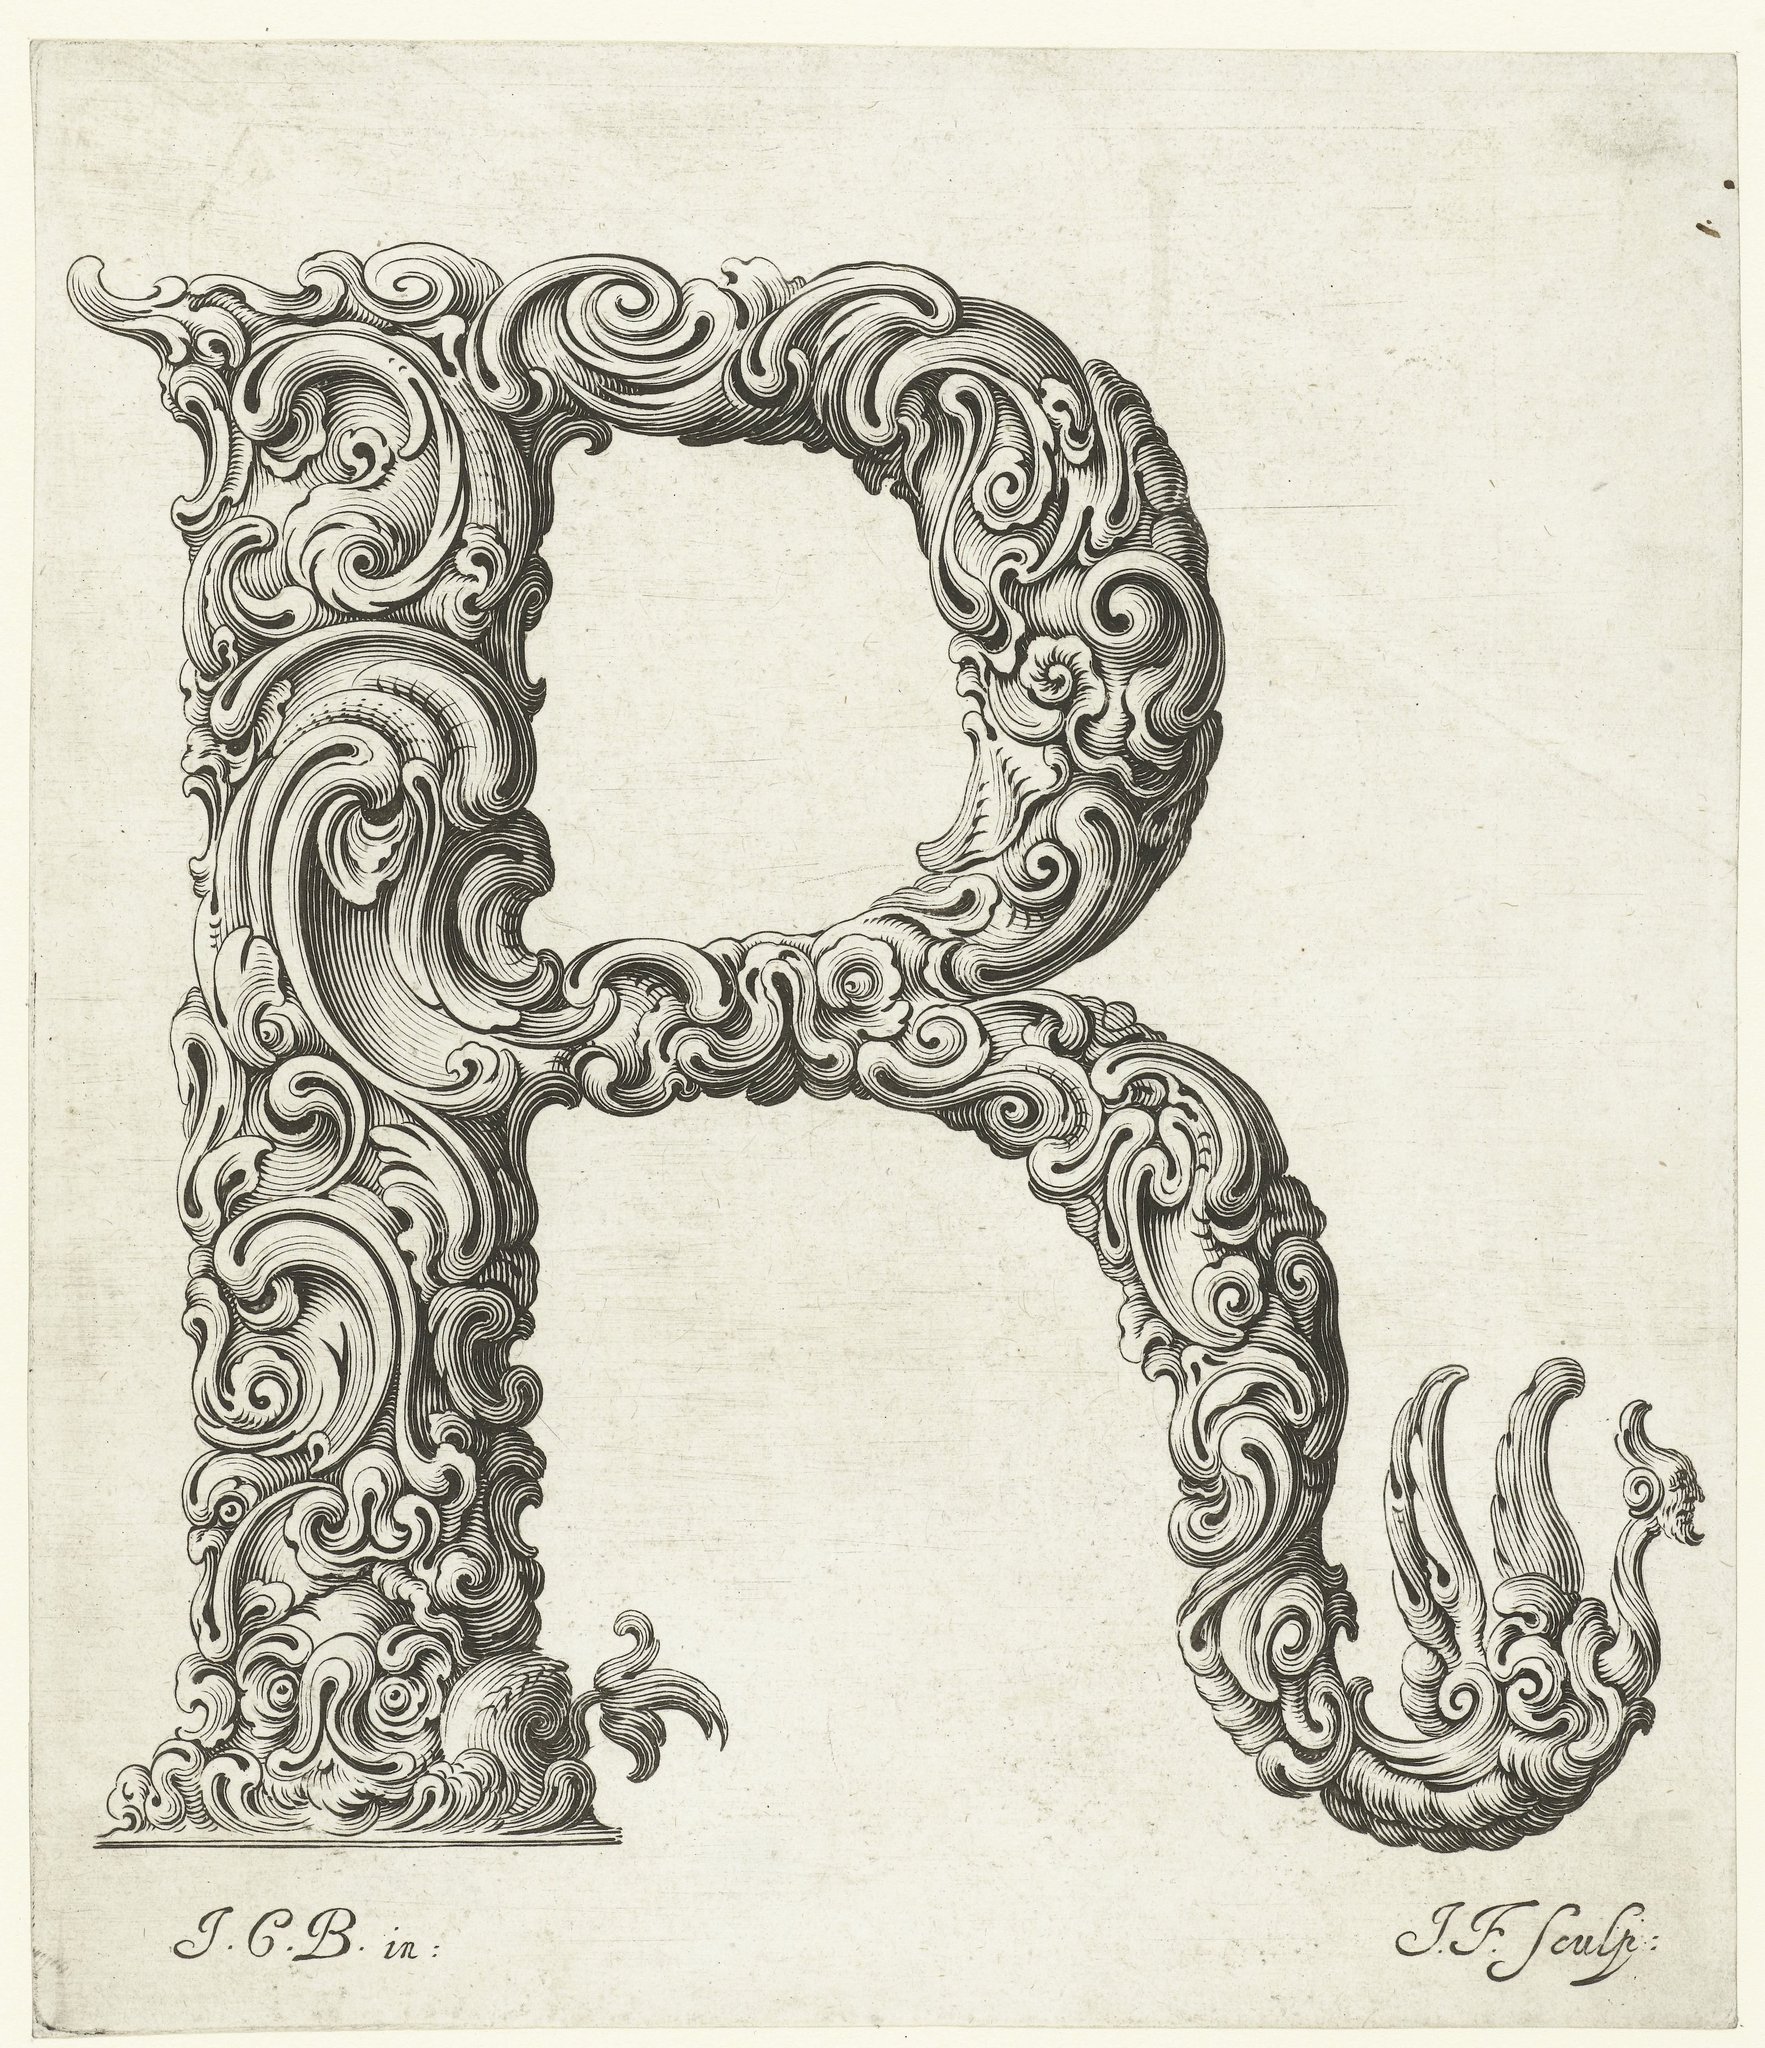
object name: print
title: Libellus Novus Elementorum Latinorum Cum AEneis picturis usui Aurifabrorum inservientib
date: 1645-1650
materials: paper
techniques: engraving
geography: germany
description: Blad met de letter R uit serie van 26 bladen met letters uit het alfabet.